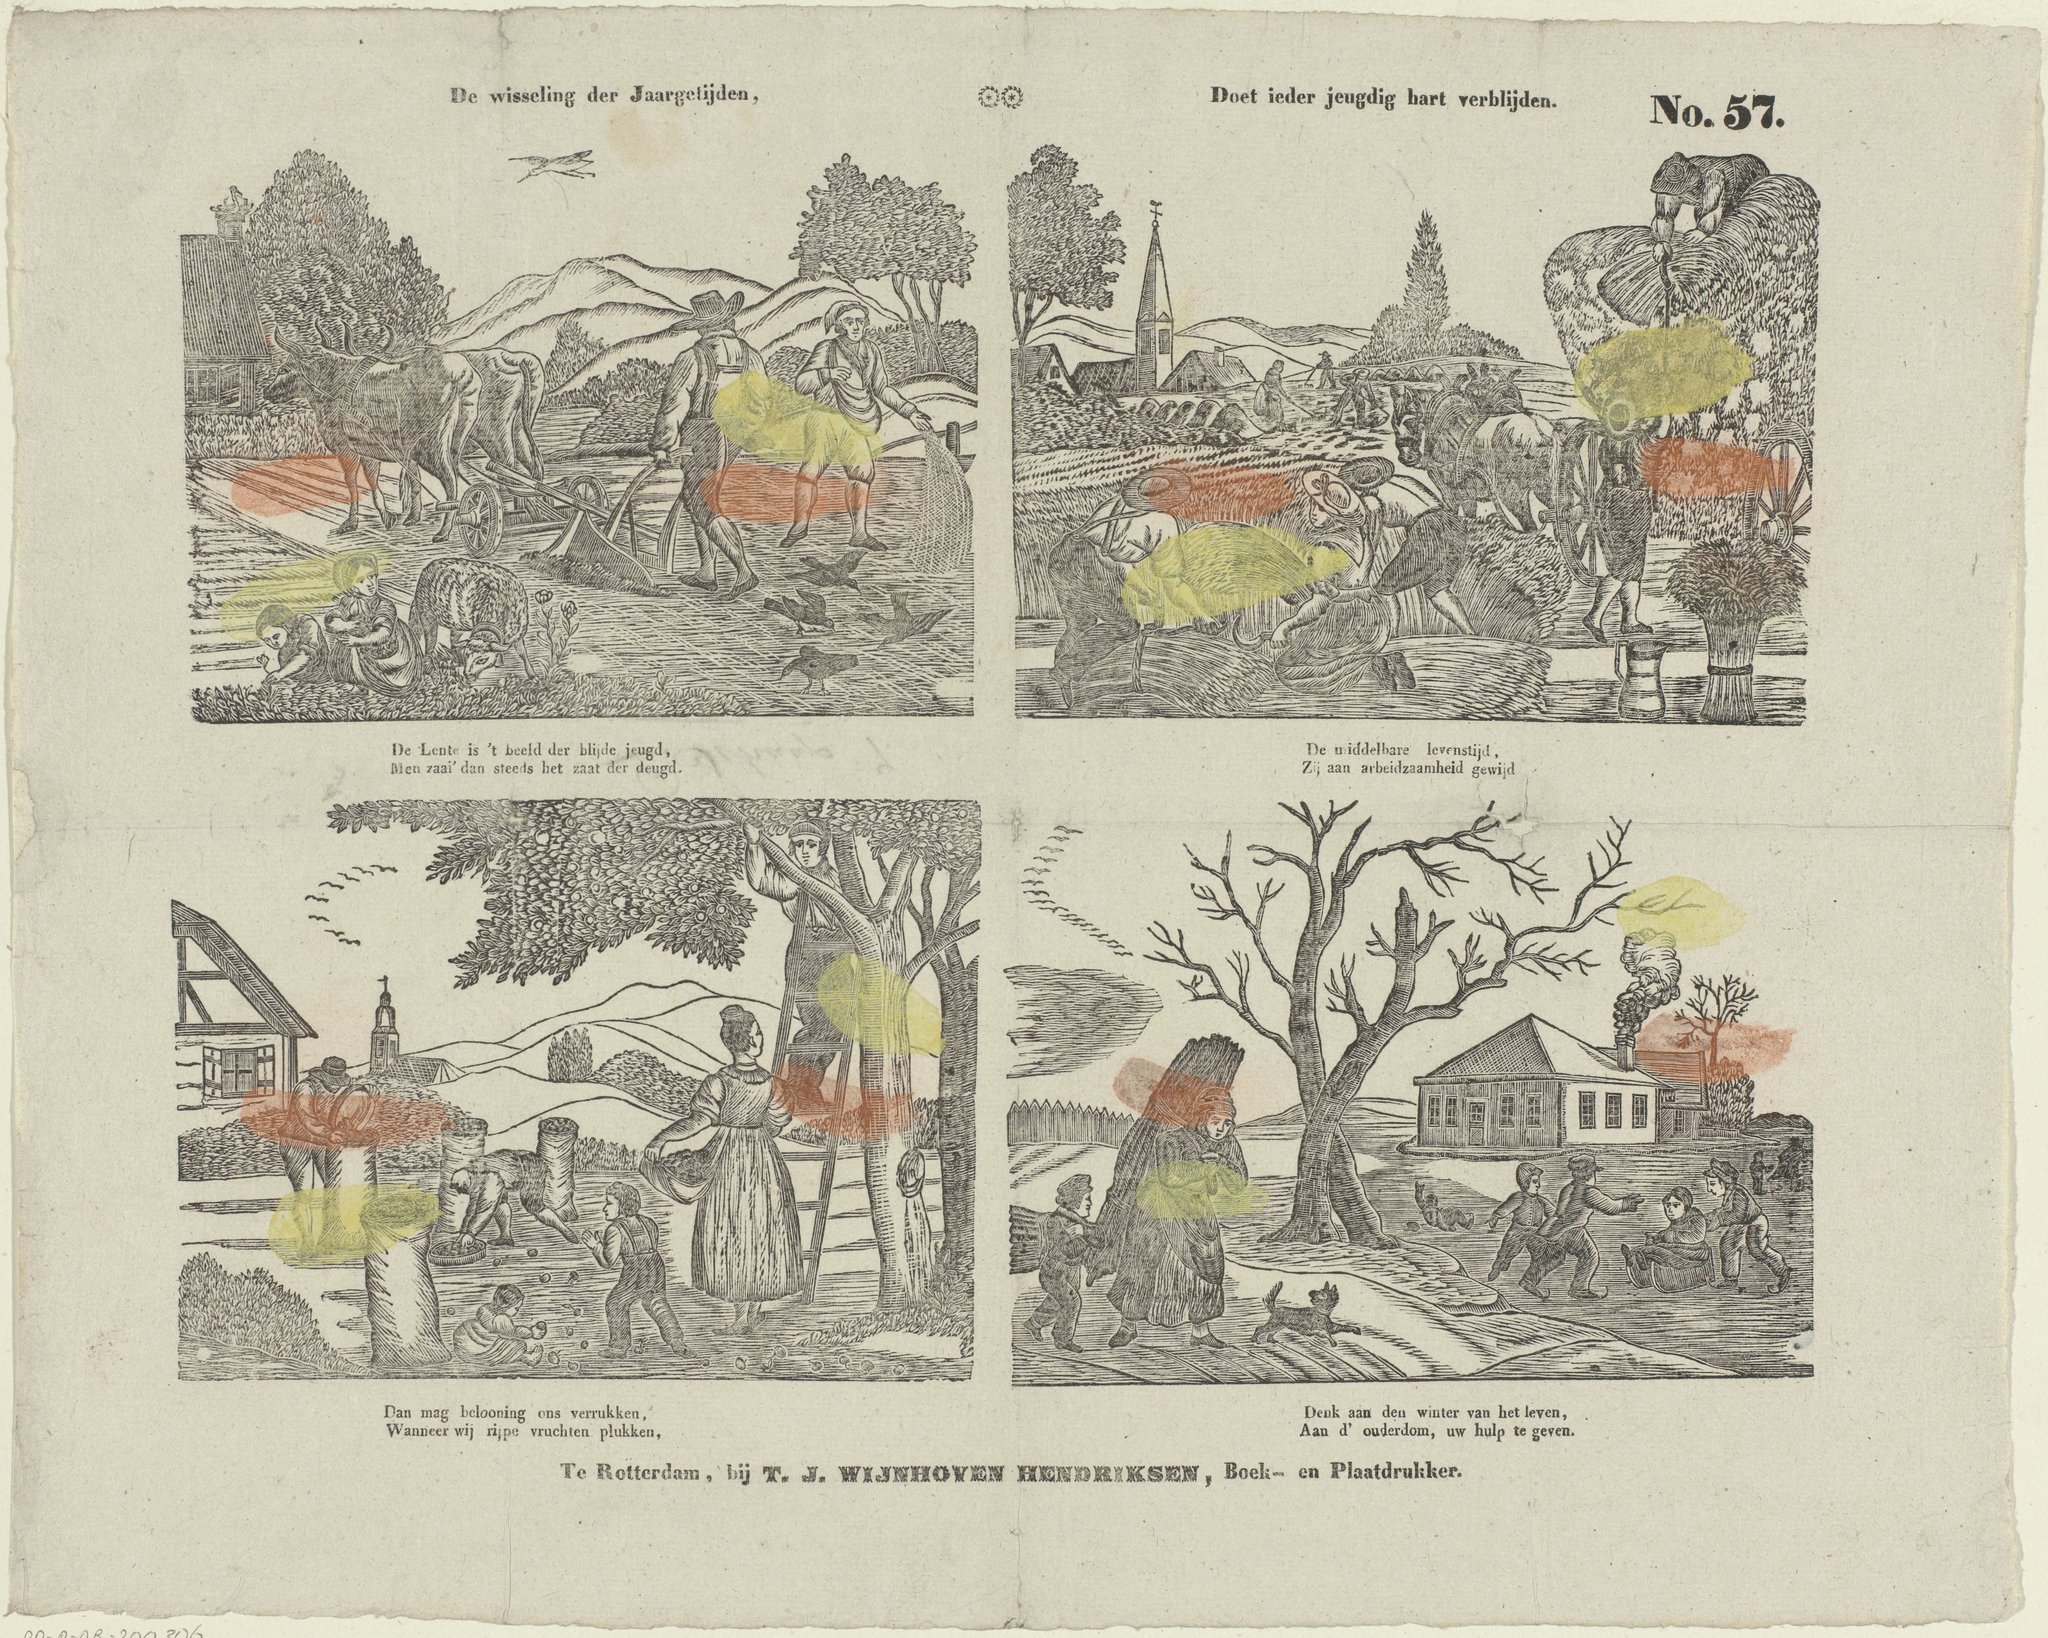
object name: print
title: De wisseling der jaargetijden, Doet ieder jeugdig hart verblijden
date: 1832-1850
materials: paper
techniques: colour, letterpress printing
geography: rotterdam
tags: the four seasons of the year ~ human activities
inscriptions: collector's mark: Lugt 2760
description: Blad met 4 voorstellingen van de jaargetijden. Onder elke afbeelding een tweergelig vers. Genummerd rechtsboven: No. 57.